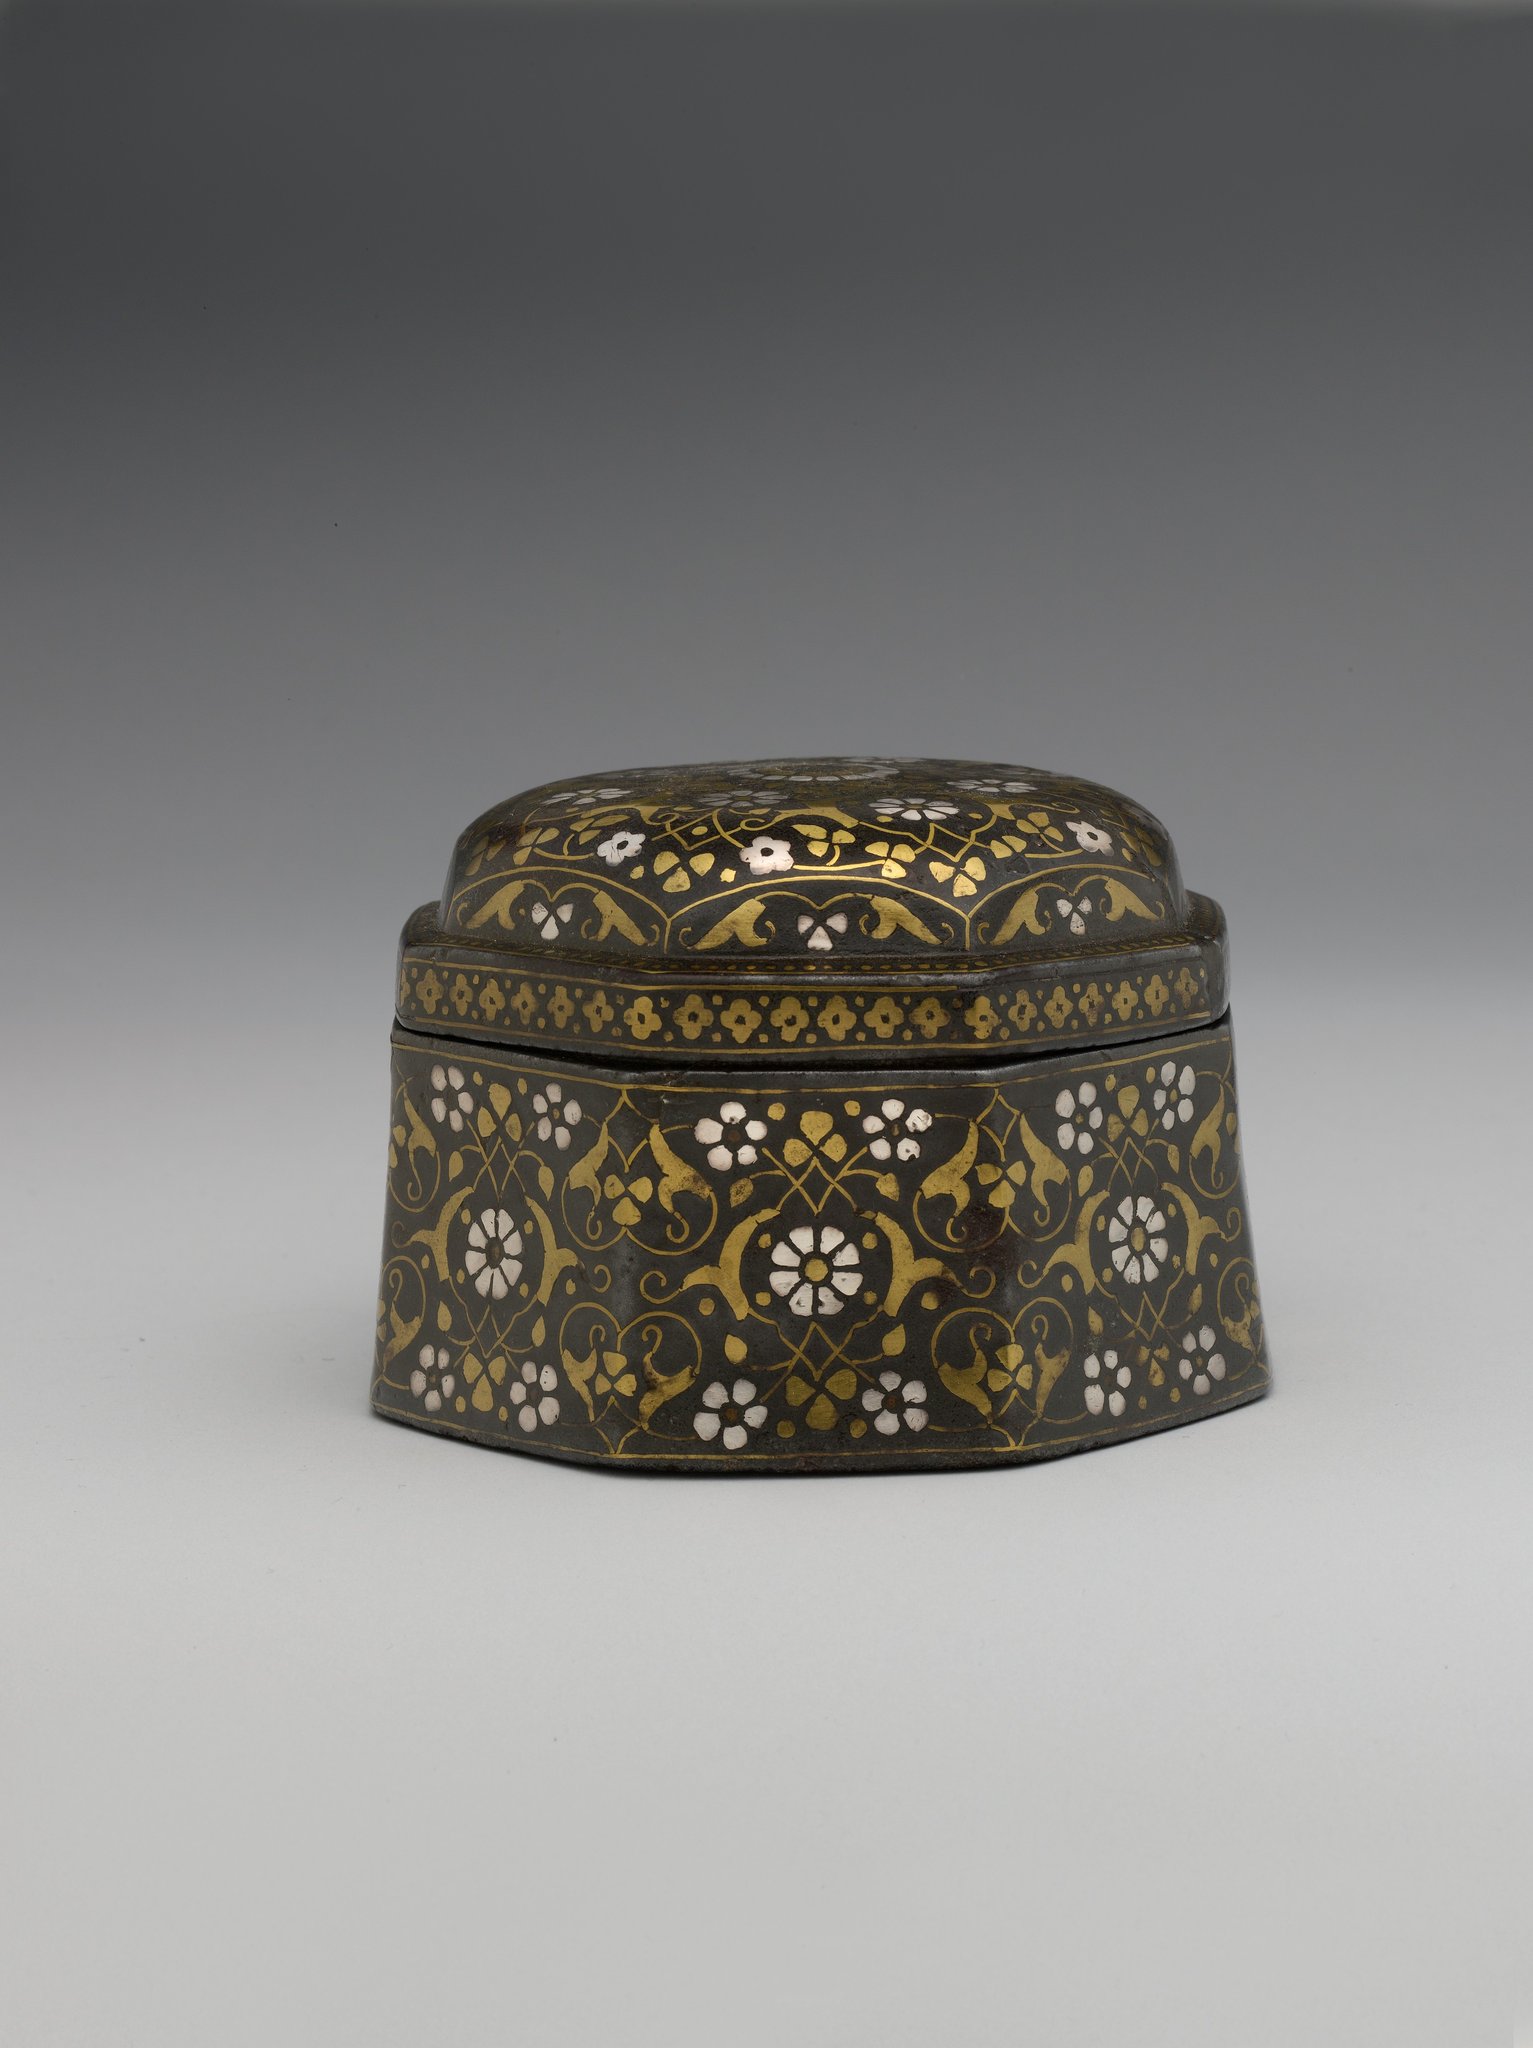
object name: box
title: Bidri Box for Holding Pan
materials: alloy, brass, silver, zinc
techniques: casting, engraving, inlay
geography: india